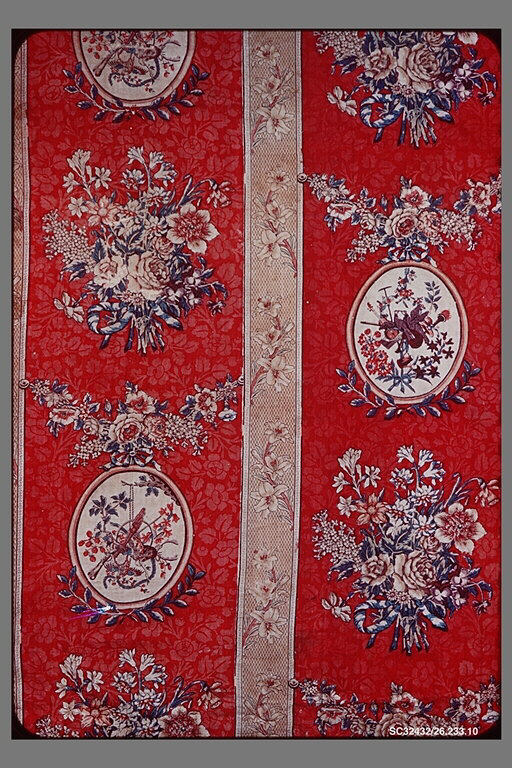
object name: hanging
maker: perrenod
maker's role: maker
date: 1785-1790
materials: cotton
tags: flowers